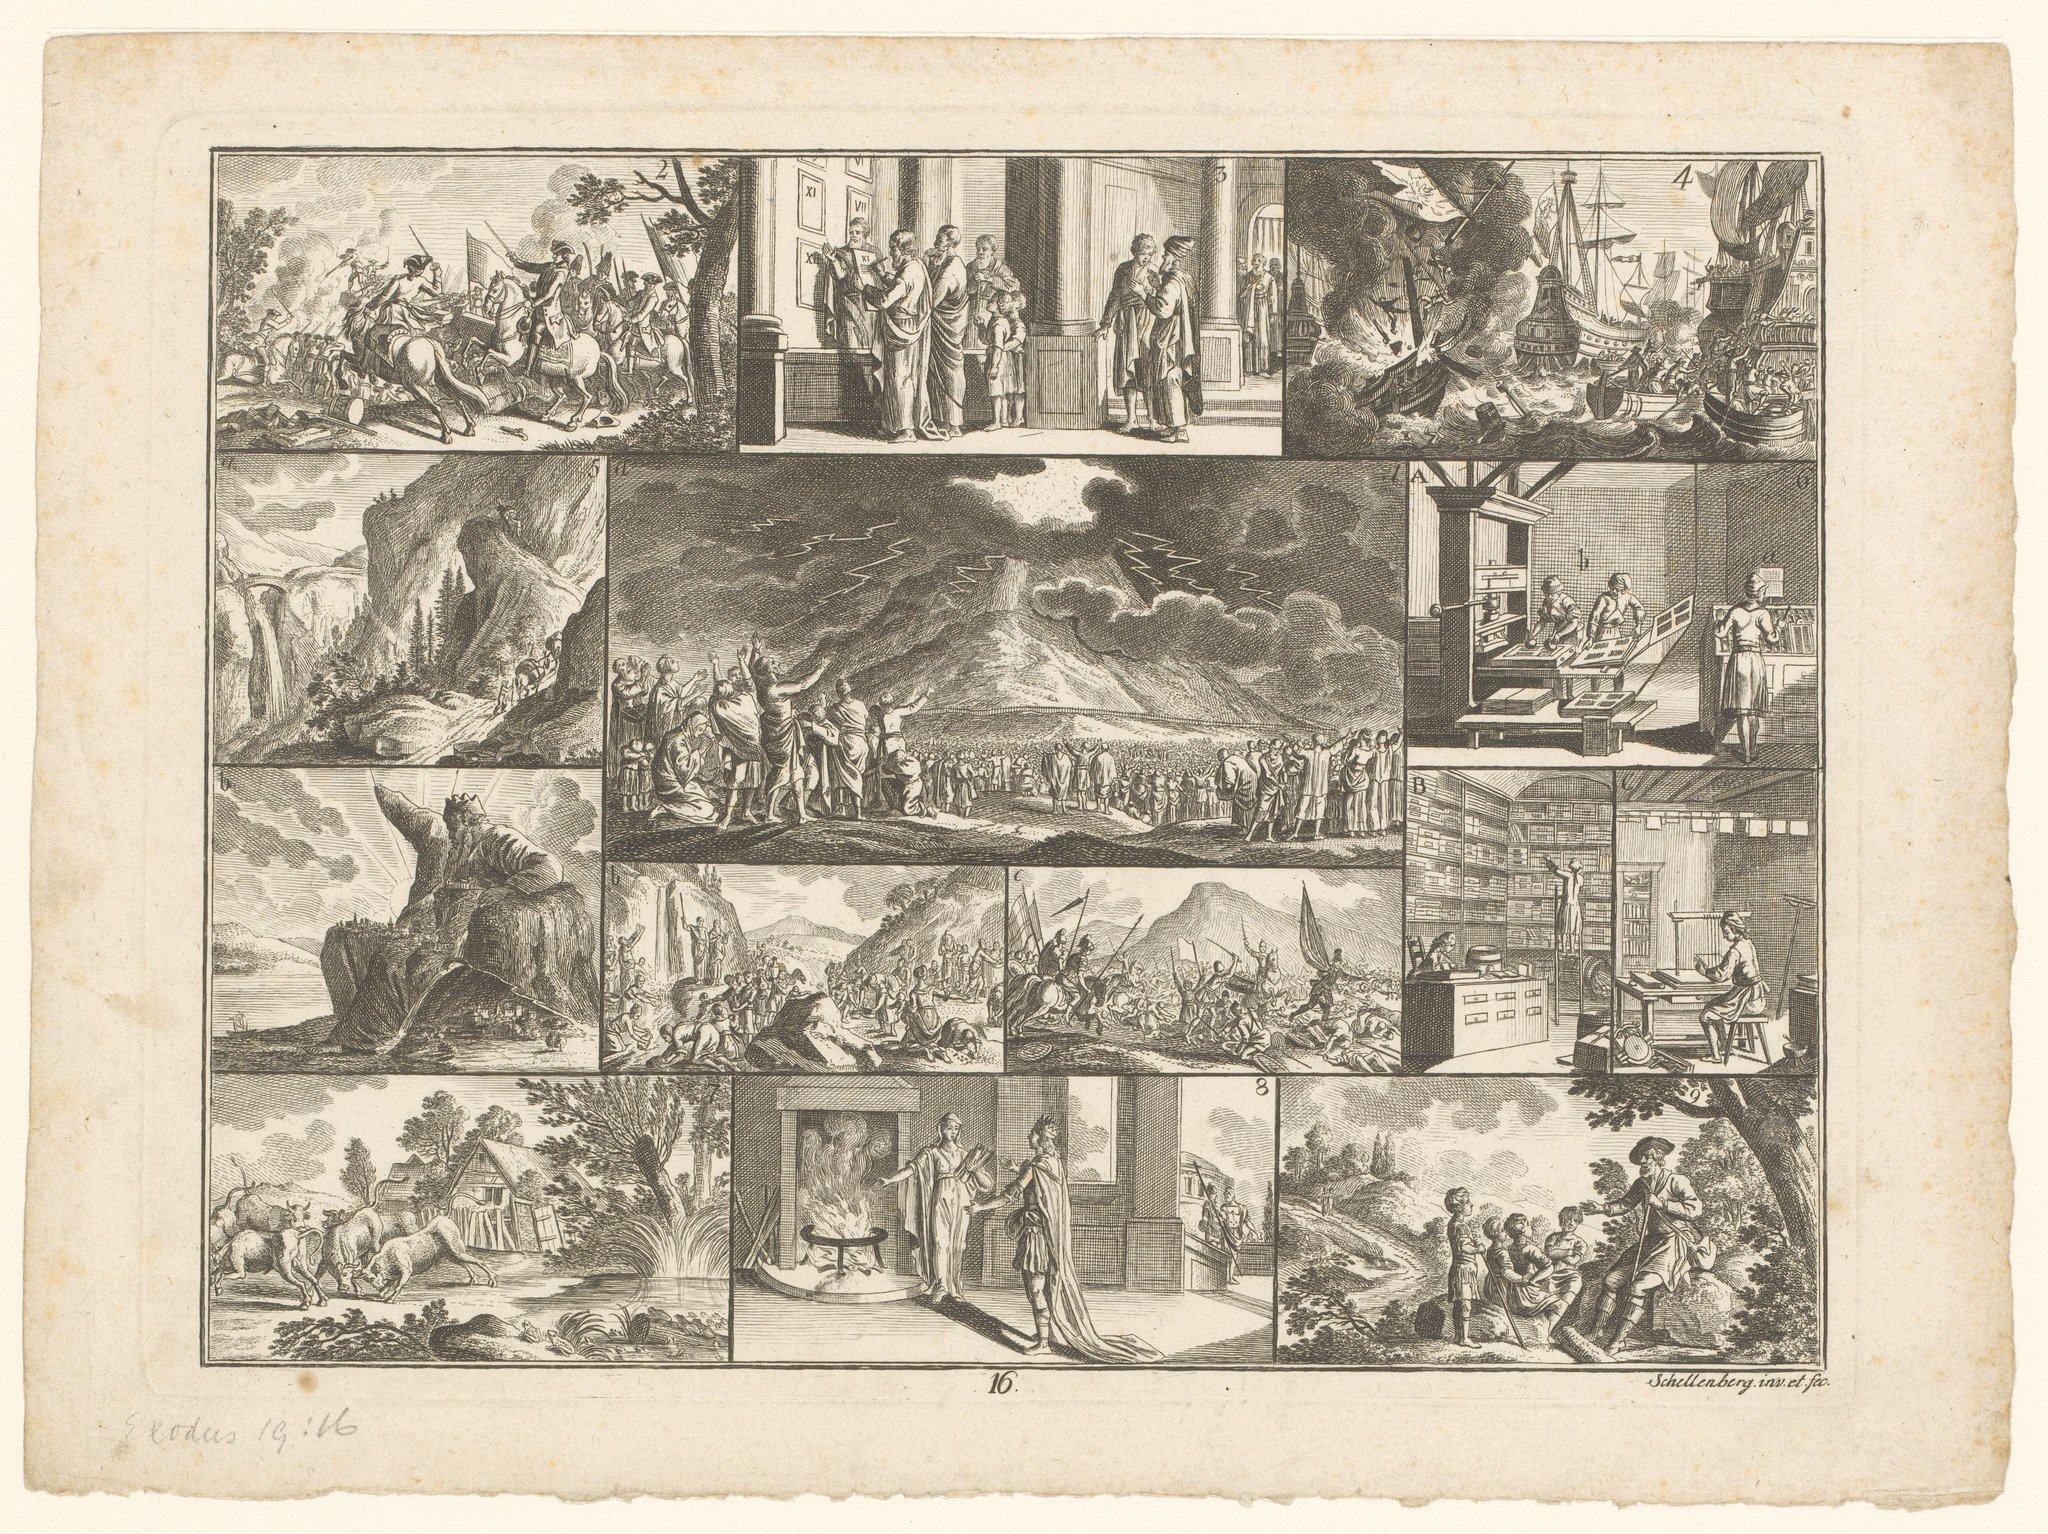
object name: print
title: Encyclopedische voorstellingen voor de jeugd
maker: johann rudolph schellenberg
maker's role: print maker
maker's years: 1740-1806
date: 1784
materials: paper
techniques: engraving, etching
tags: moses communicating with god on mount sinai (the mountain may be covered by a thick cloud), mount sinai is covered by a thick cloud, thunder and lightning, production of printed matter, book-production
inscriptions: collector's mark: Lugt 2228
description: Maakt deel uit van een serie encyclopedische prenten door verschillende kunstenaars naar ontwerp van Daniel Nikolaus Chodowiecki bij Johann Sigmund Stoy's 'Bilder-Akademie für die Jugend', uitgegeven te Neurenberg in 1784. De prenten waren bedoeld voor kinderen om uit te knippen, op kaarten te plakken en vervolgens op logische wijze te rangschikken (zie Heesen, Anke te. The World in a Box: The Story of an Eighteenth-Century Picture Encyclopedia. Chicago: University of Chicago Press, 2002).